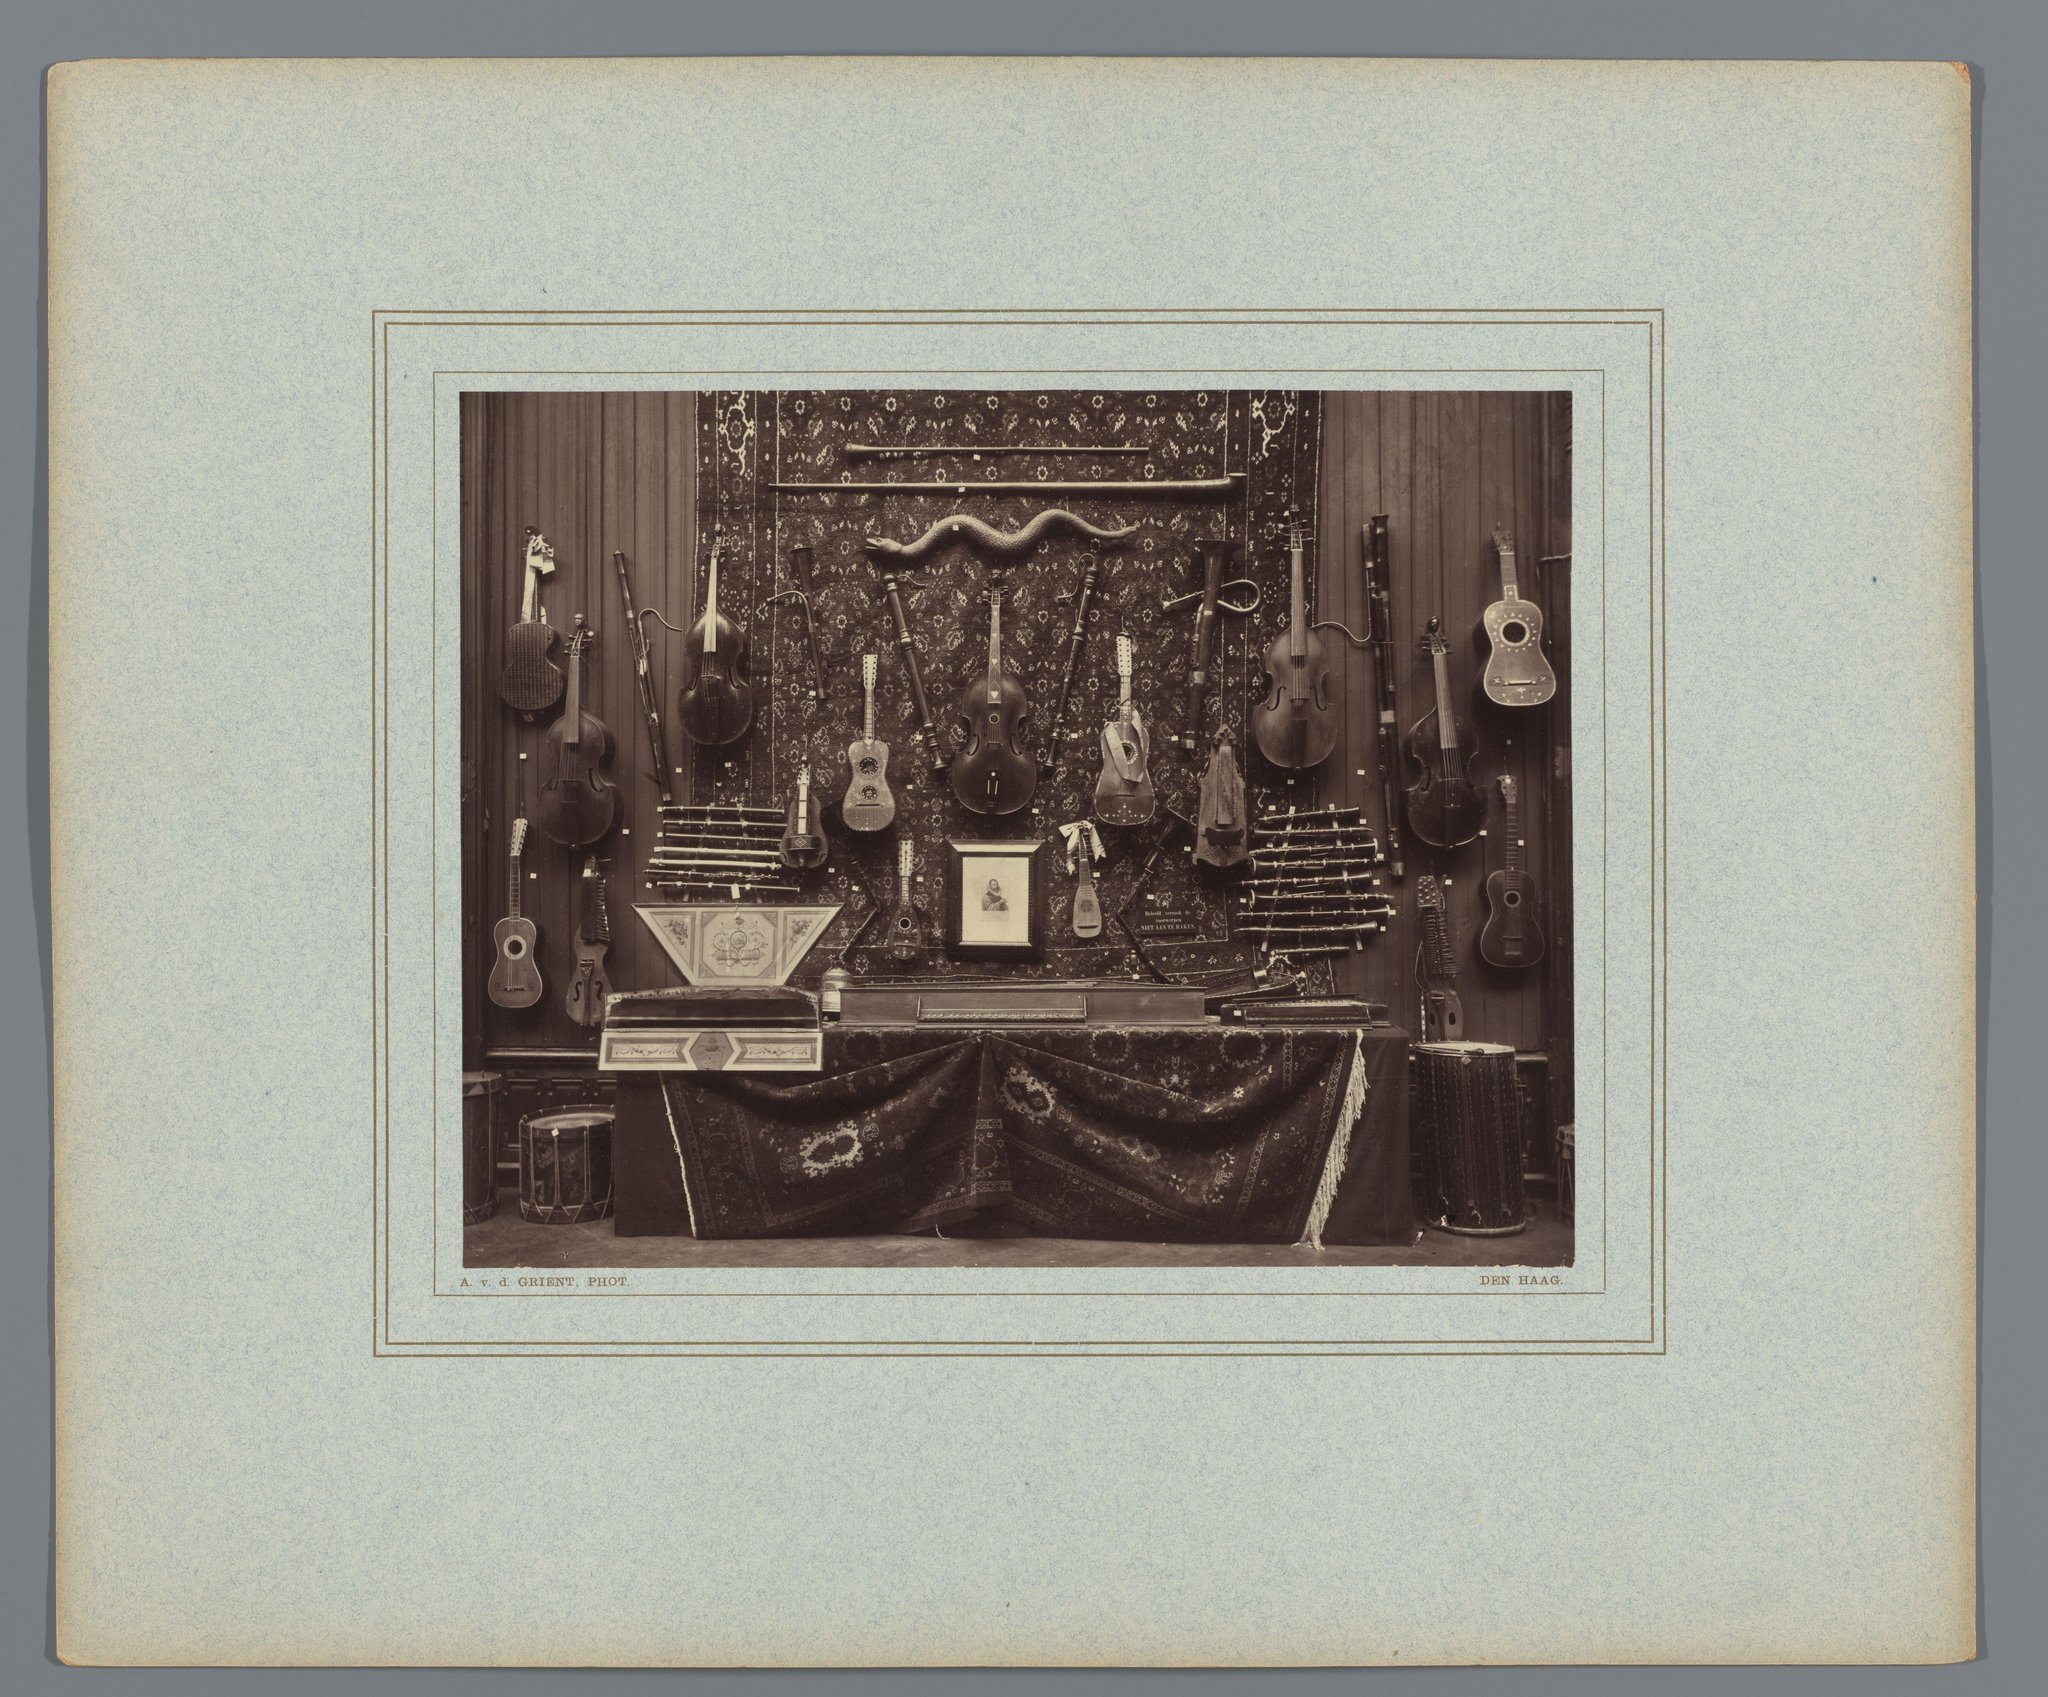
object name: photomechanical print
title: Muziekinstrumenten uit de collectie Daniël François Scheurleer, tentoongesteld in Pulchri Studio in 1893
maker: adrianus van der grient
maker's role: fotograaf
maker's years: 1858-1941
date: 1893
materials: cardboard, paper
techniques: woodburytype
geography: pulchri studio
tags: the hague, daniël françois lunsingh scheurleer, musical instruments; group of musical instruments, exhibition ~ art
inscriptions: inscription: ‘A. v. d. GRIENT, PHOT. - DEN HAAG.’